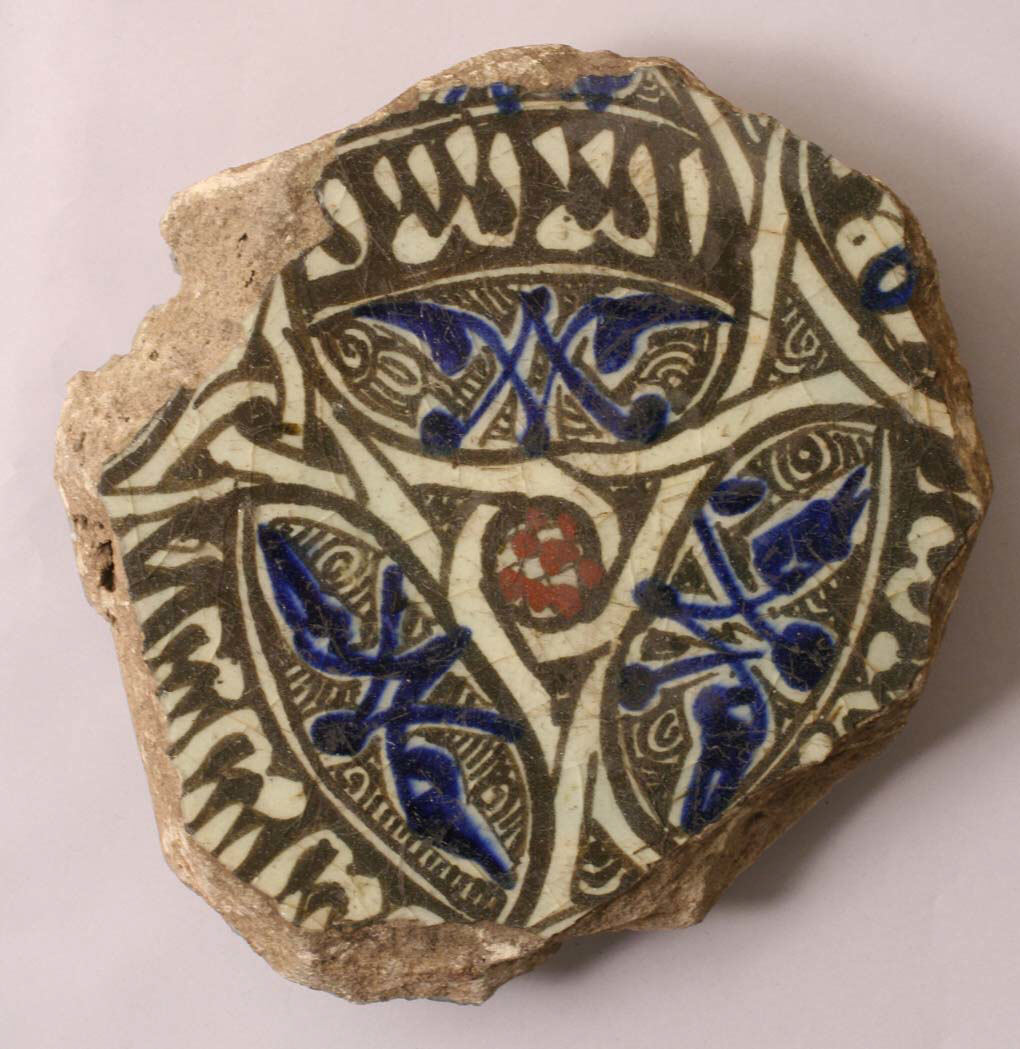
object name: fragment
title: Fragment of Bowl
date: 1301-1400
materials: glaze, stonepaste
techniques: painting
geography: syria